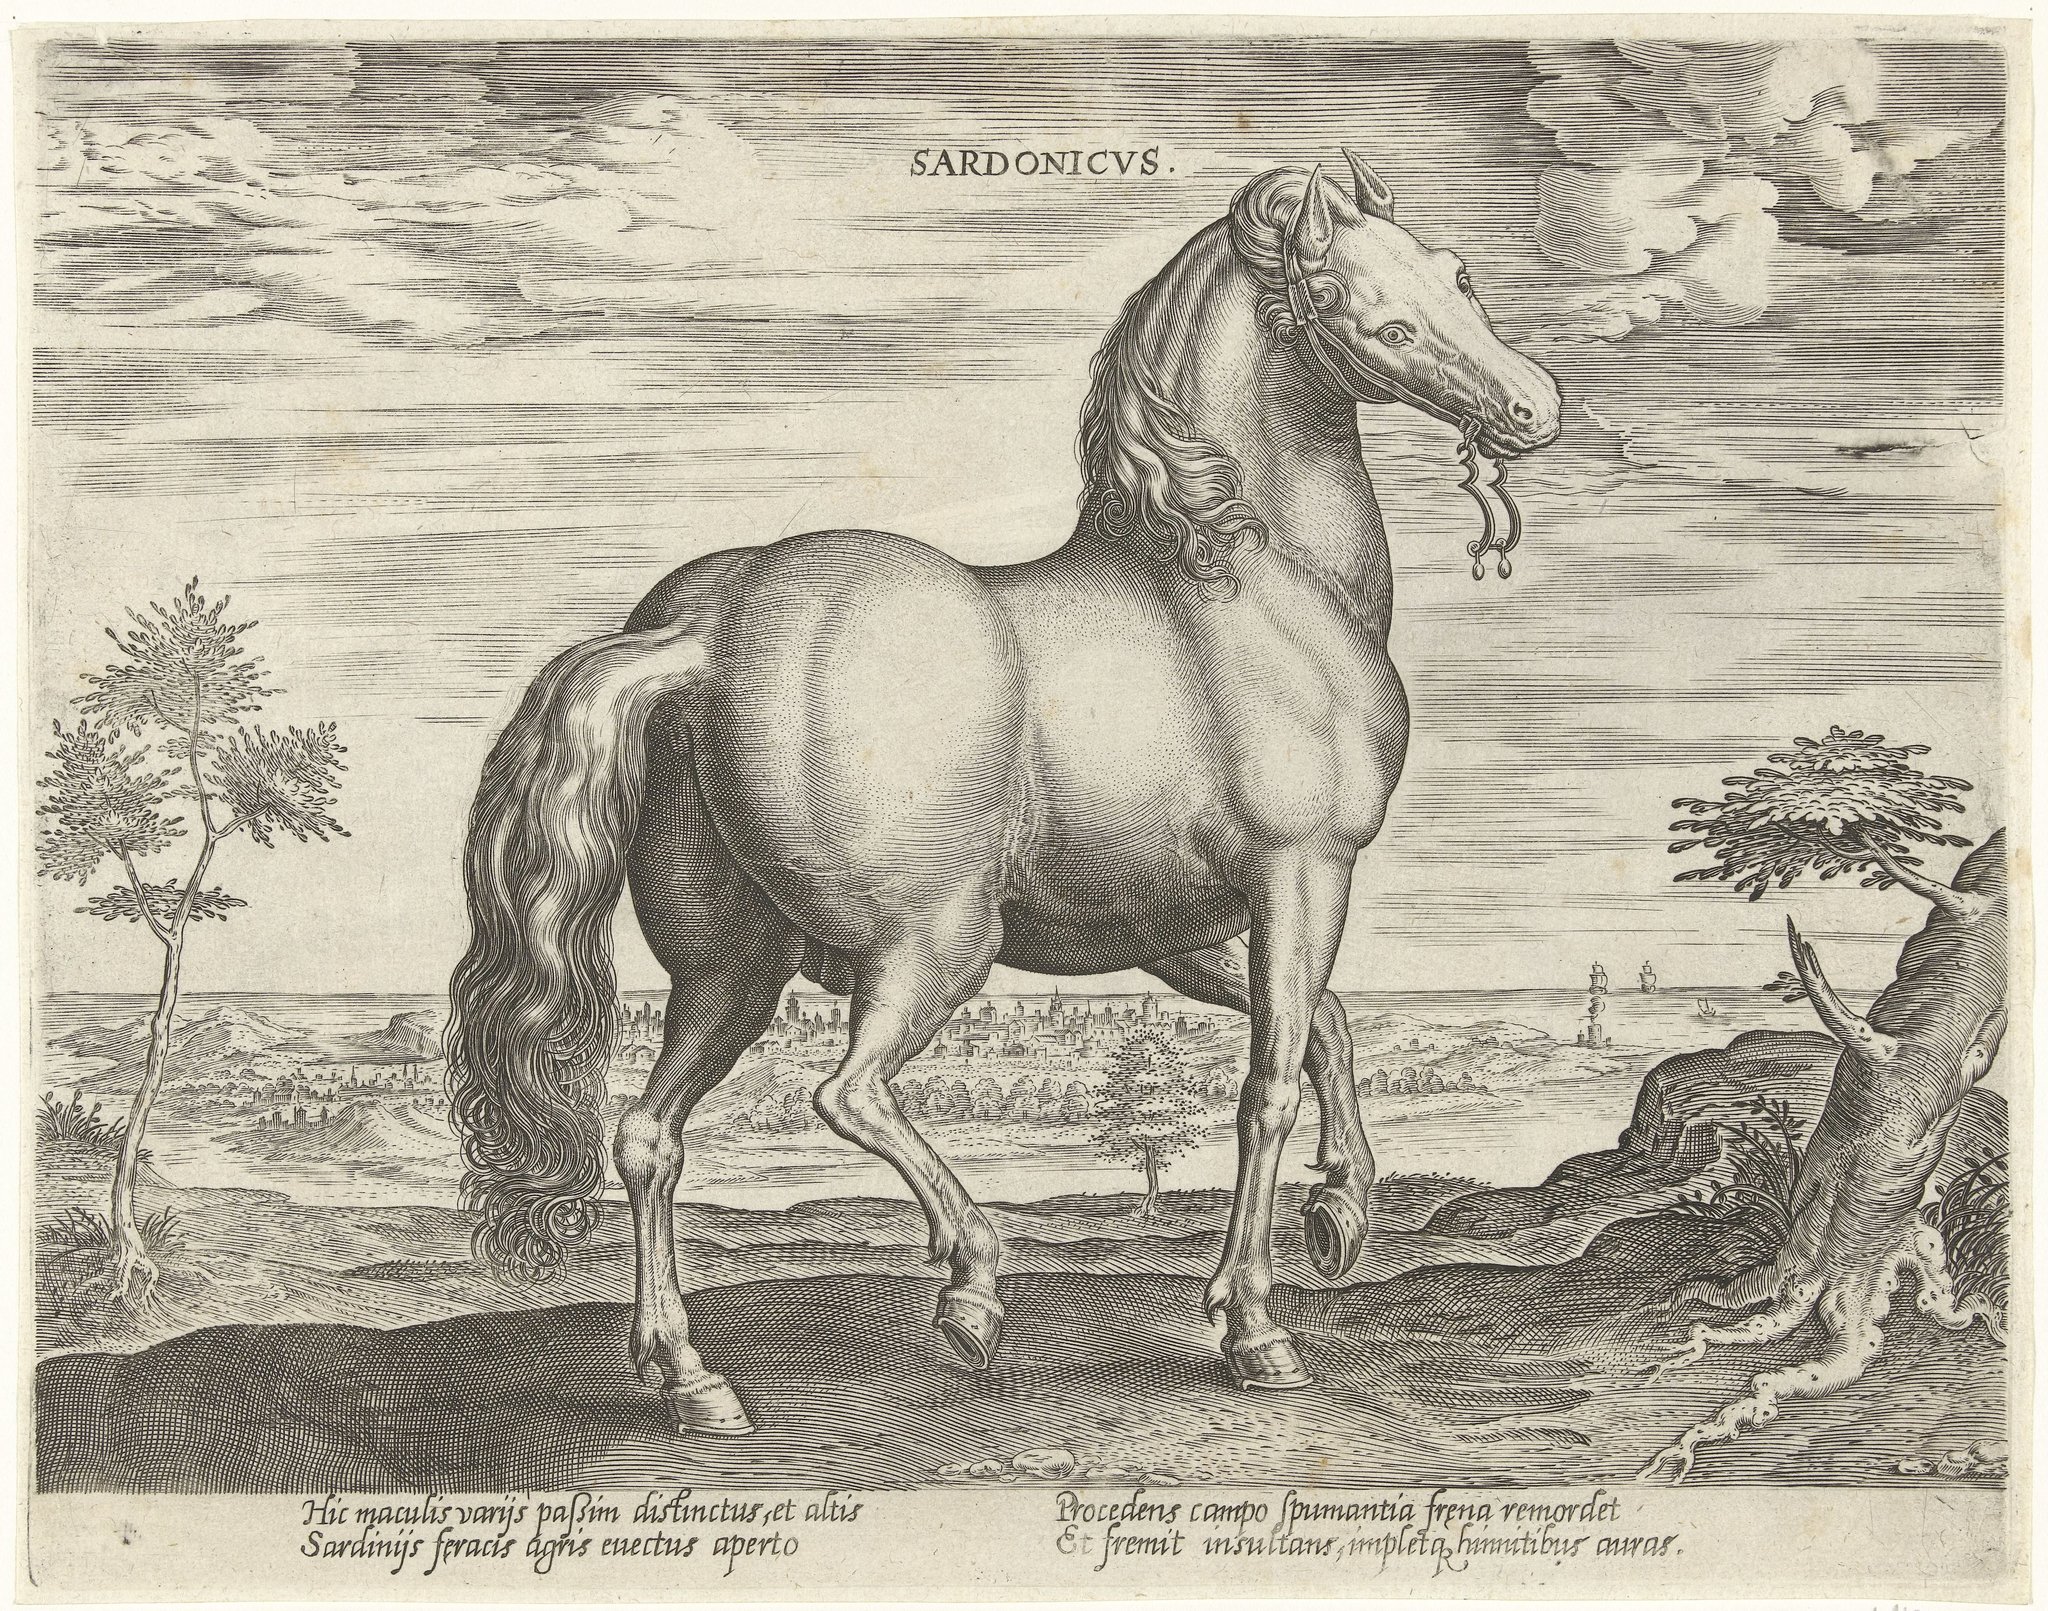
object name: print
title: Paard uit Sardinië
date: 1578-1582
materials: paper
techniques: engraving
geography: haarlem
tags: don juan van oostenrijk, horses and kindred animals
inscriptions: collector's mark: Lugt 2228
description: Een Sardinisch paard, van achteren. De prent heeft een Latijns onderschrift en maakt deel uit van het derde deel van een 39-delige serie over de paardenrassen uit Koninklijke stallen van Don Juan van Oostenrijk.